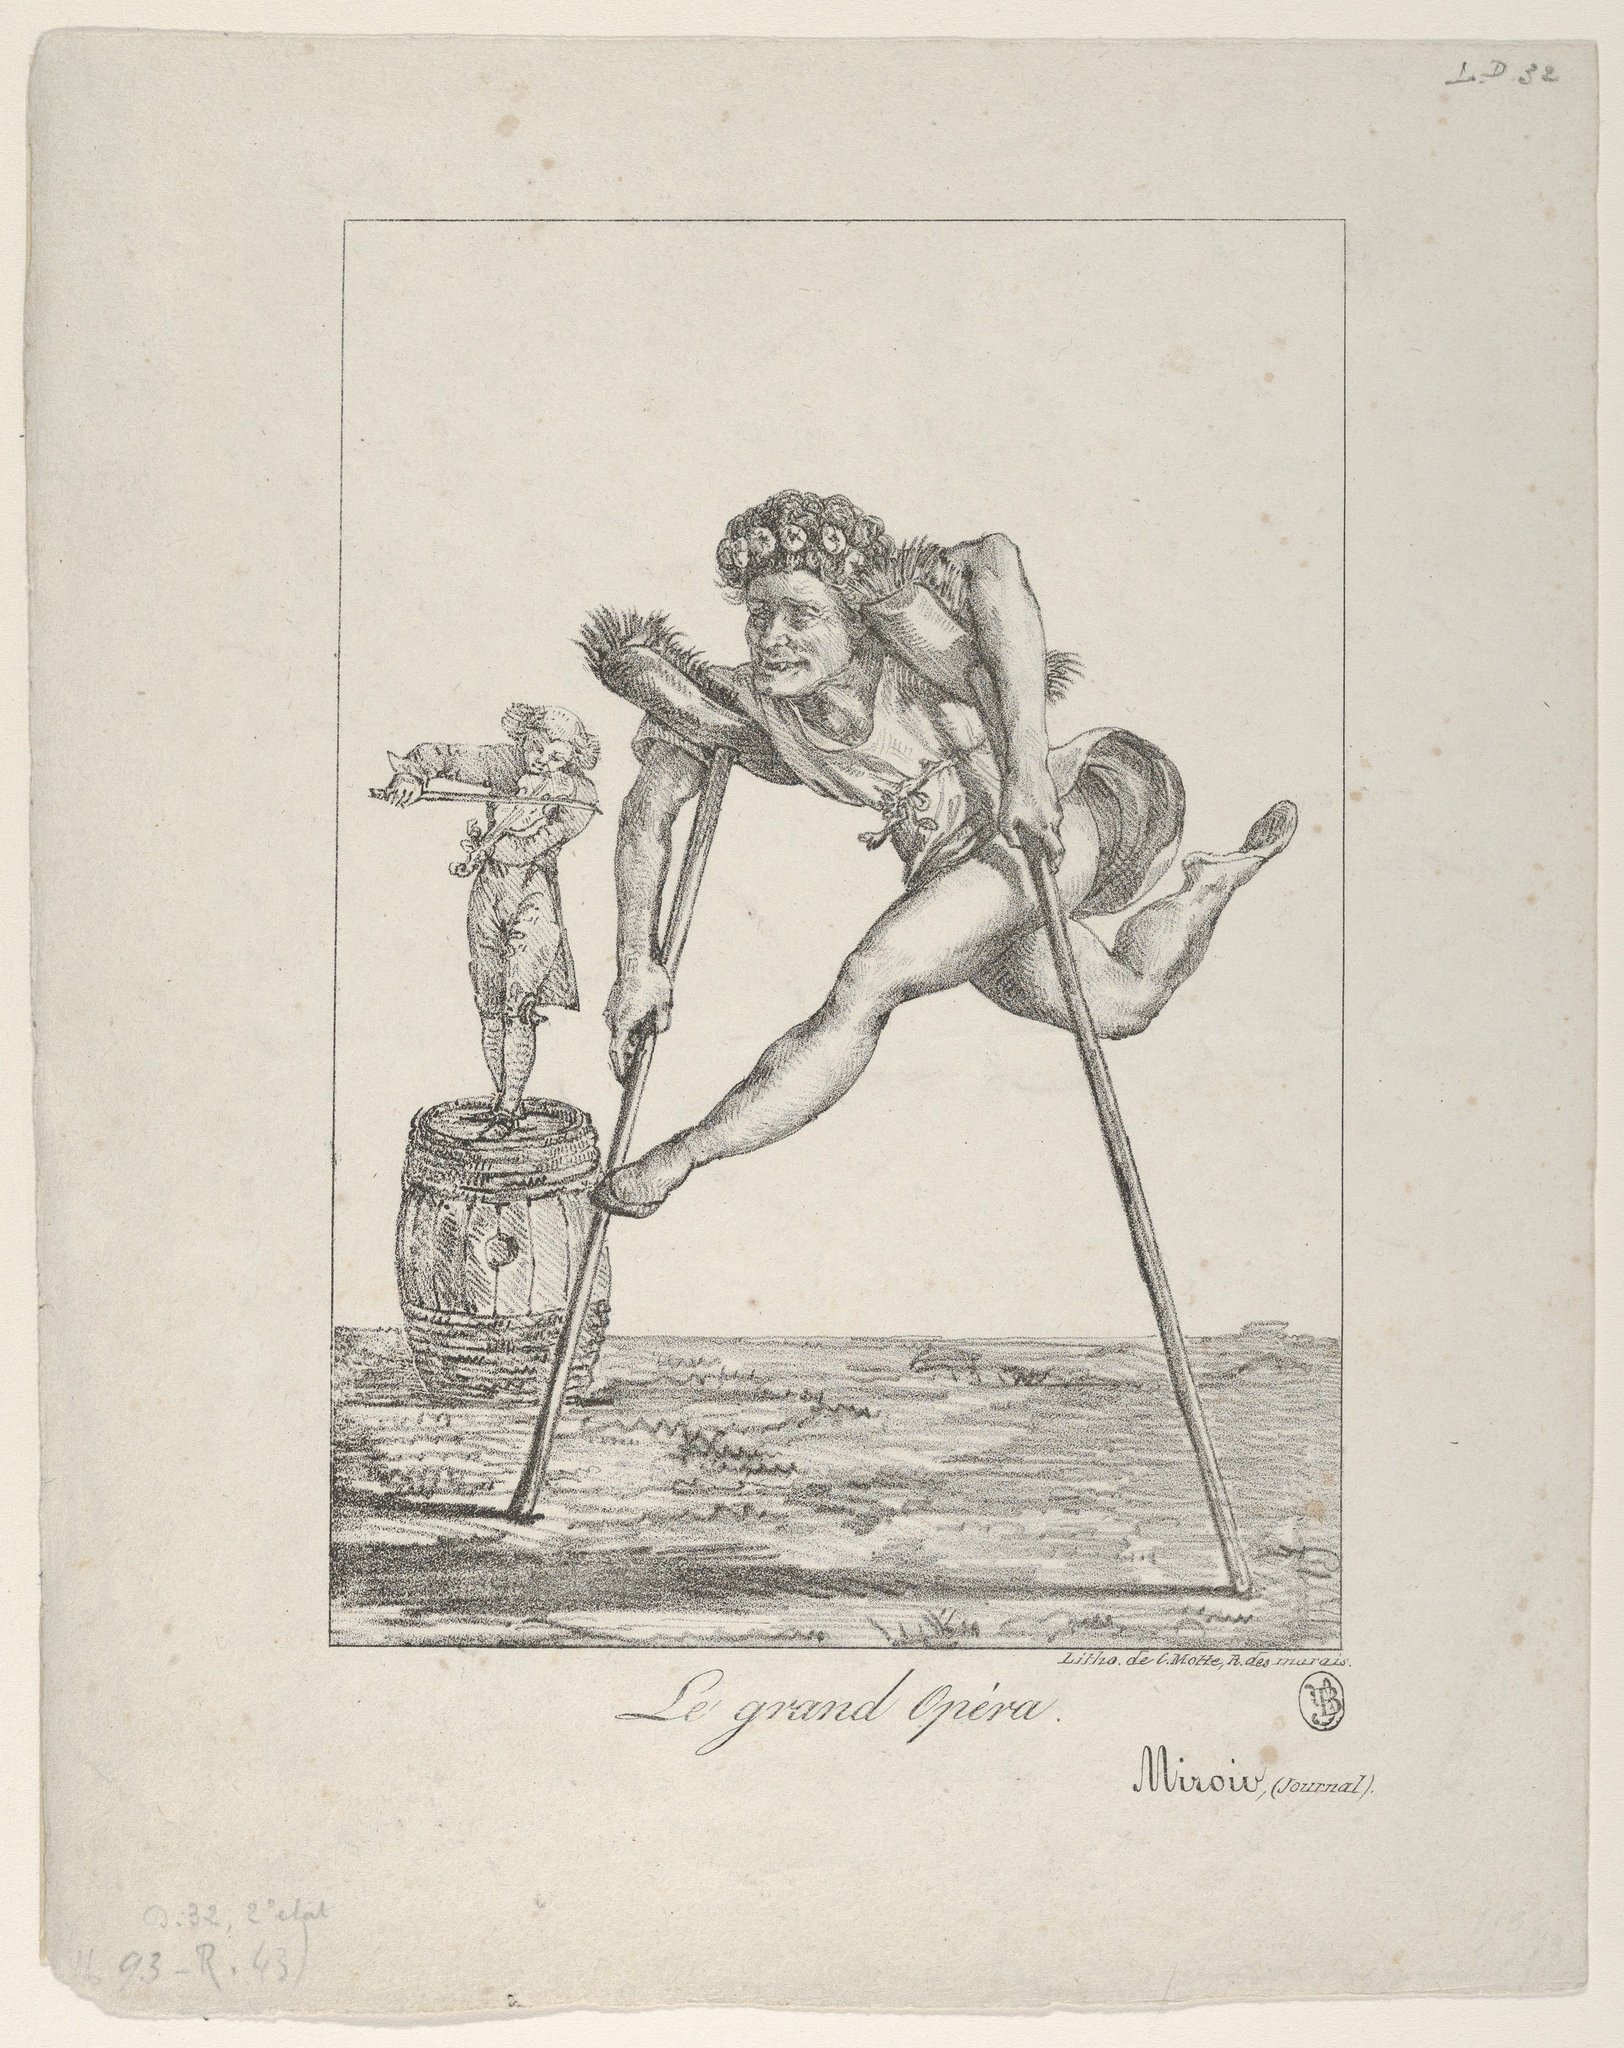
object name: print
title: Le Grand Opéra, from "Le Miroir"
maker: eugène delacroix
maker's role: artist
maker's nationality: french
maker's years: 1798-1863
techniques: lithograph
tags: opera,performance,men,violins